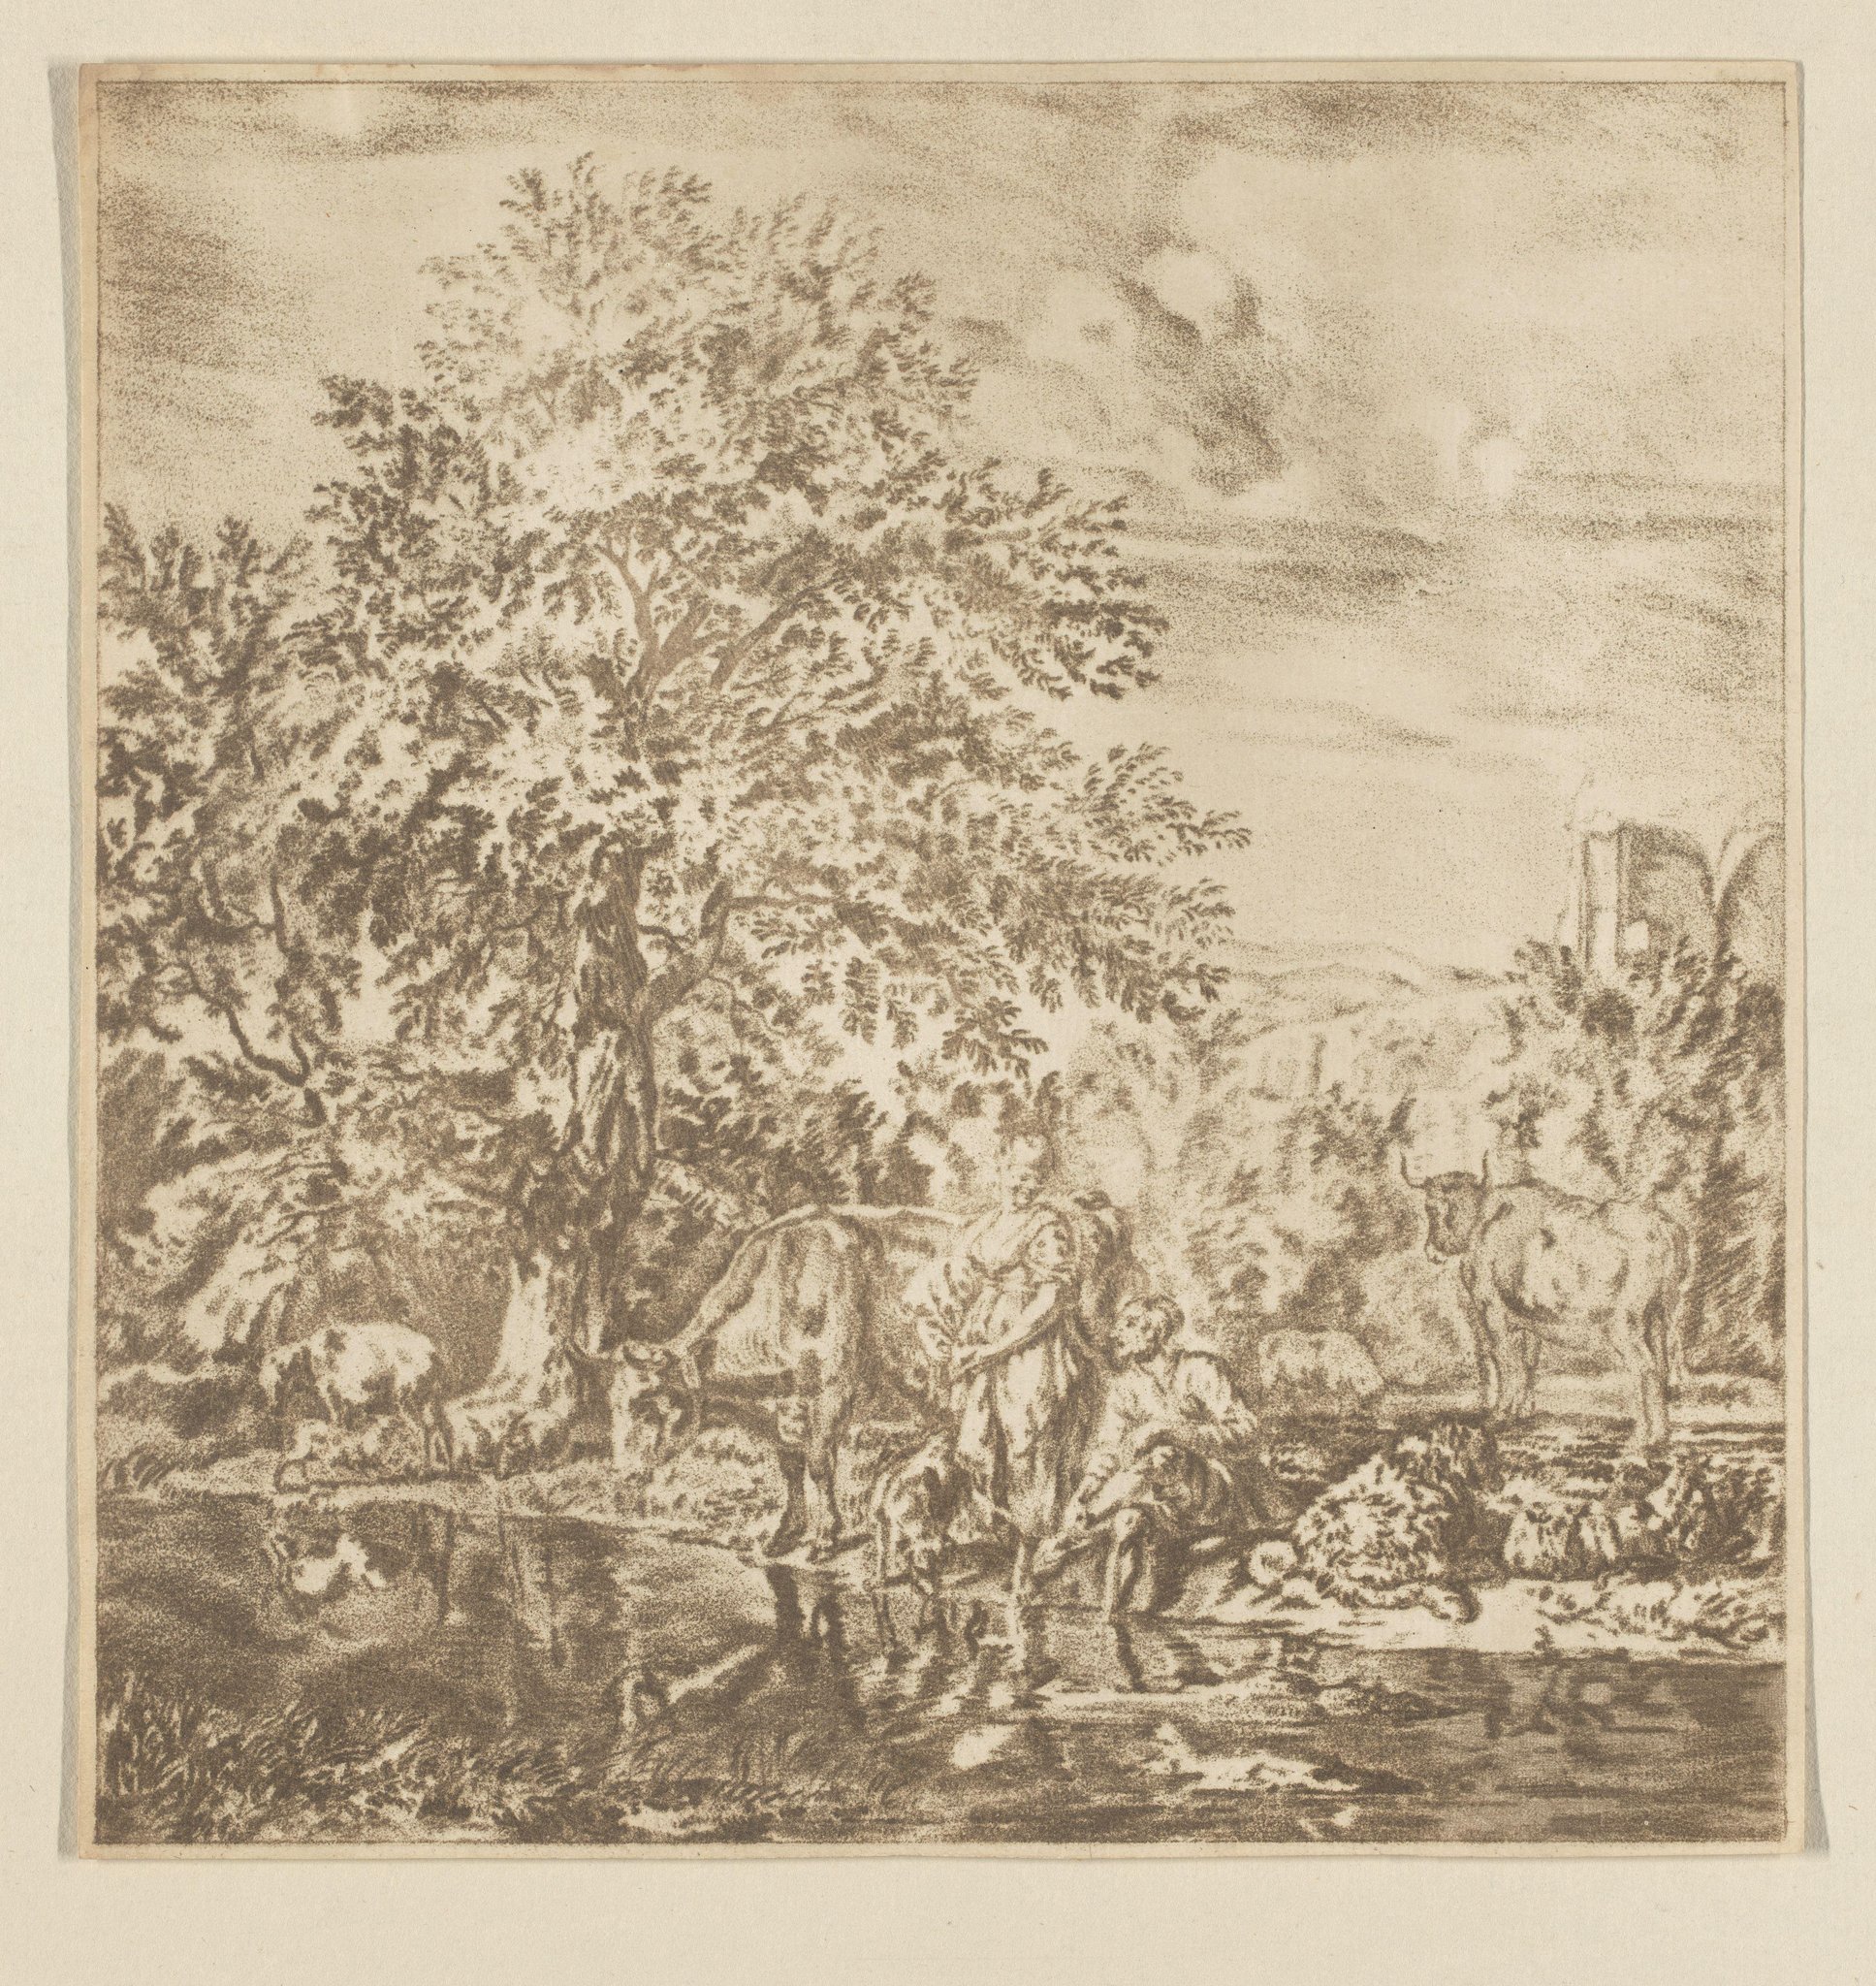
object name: print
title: Herder en herderin met kudde bij een rivier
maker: cornelis ploos van amstel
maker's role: draughtsman, print maker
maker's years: 1726-1798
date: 1763-1765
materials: paper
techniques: transfer, print drawing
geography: amsterdam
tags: cow, herding, herdsman, herdswoman, shepherd, shepherdess, cowherd, etc., sheep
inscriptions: collector's mark: ‘RIJKS / MUSM’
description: Een herder en een herderin staan op de oever van een rivier met hun schapen en koeien. De prent ligt los in een album, zie blad 4.